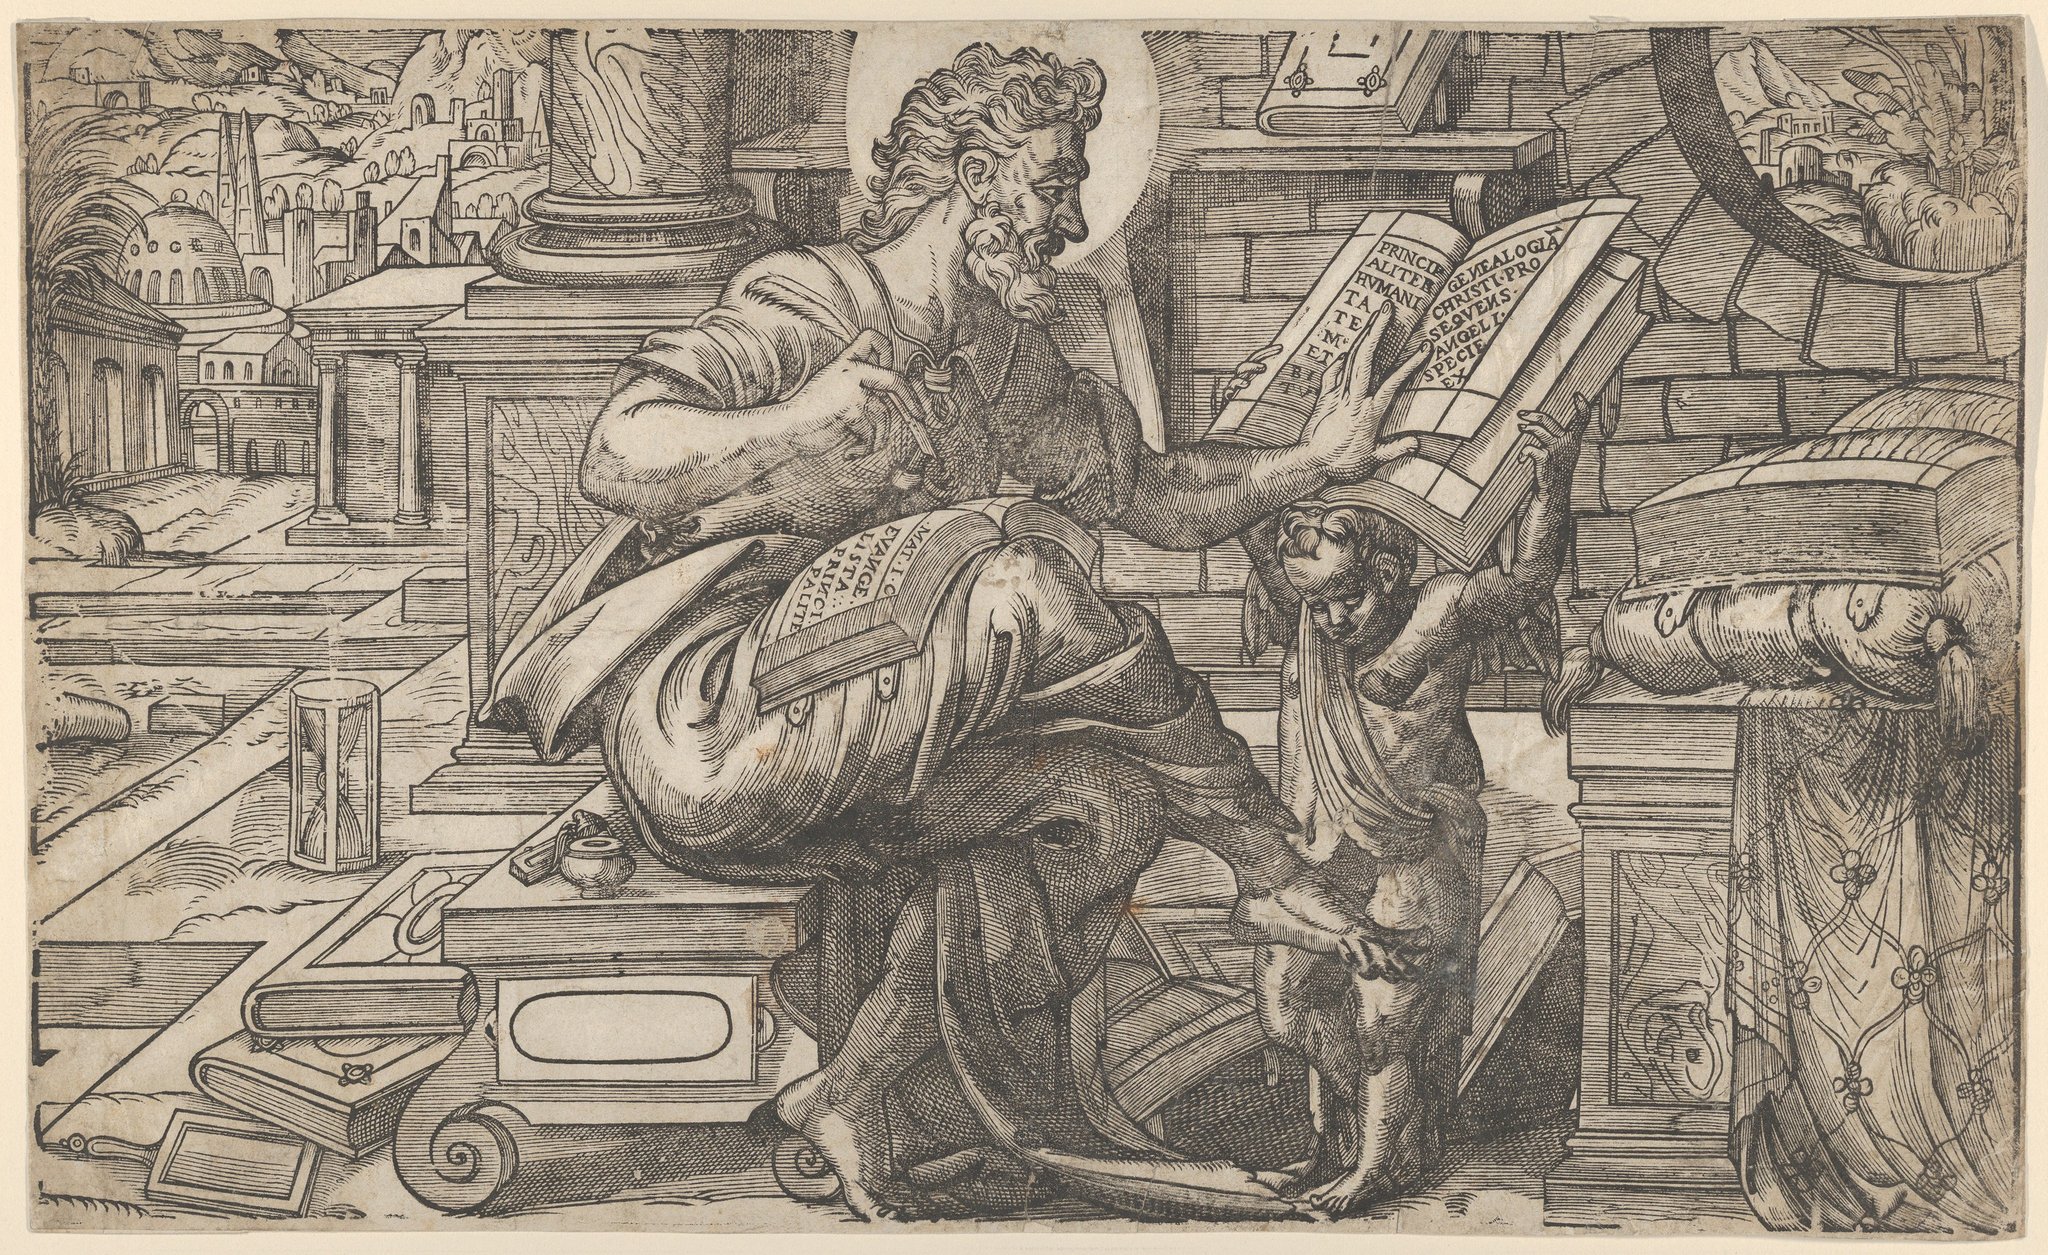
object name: print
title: Saint Matthew seated and reading from a book held by a putto, set within a fanciful architectural backdrop, from a series of woodcuts of the Four Evangelists, copy after Rue Montorgueil woodcut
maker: anthony van leest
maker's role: artist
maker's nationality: netherlandish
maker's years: 1545-1592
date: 1565-1575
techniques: woodcut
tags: reading,putti,saint matthew